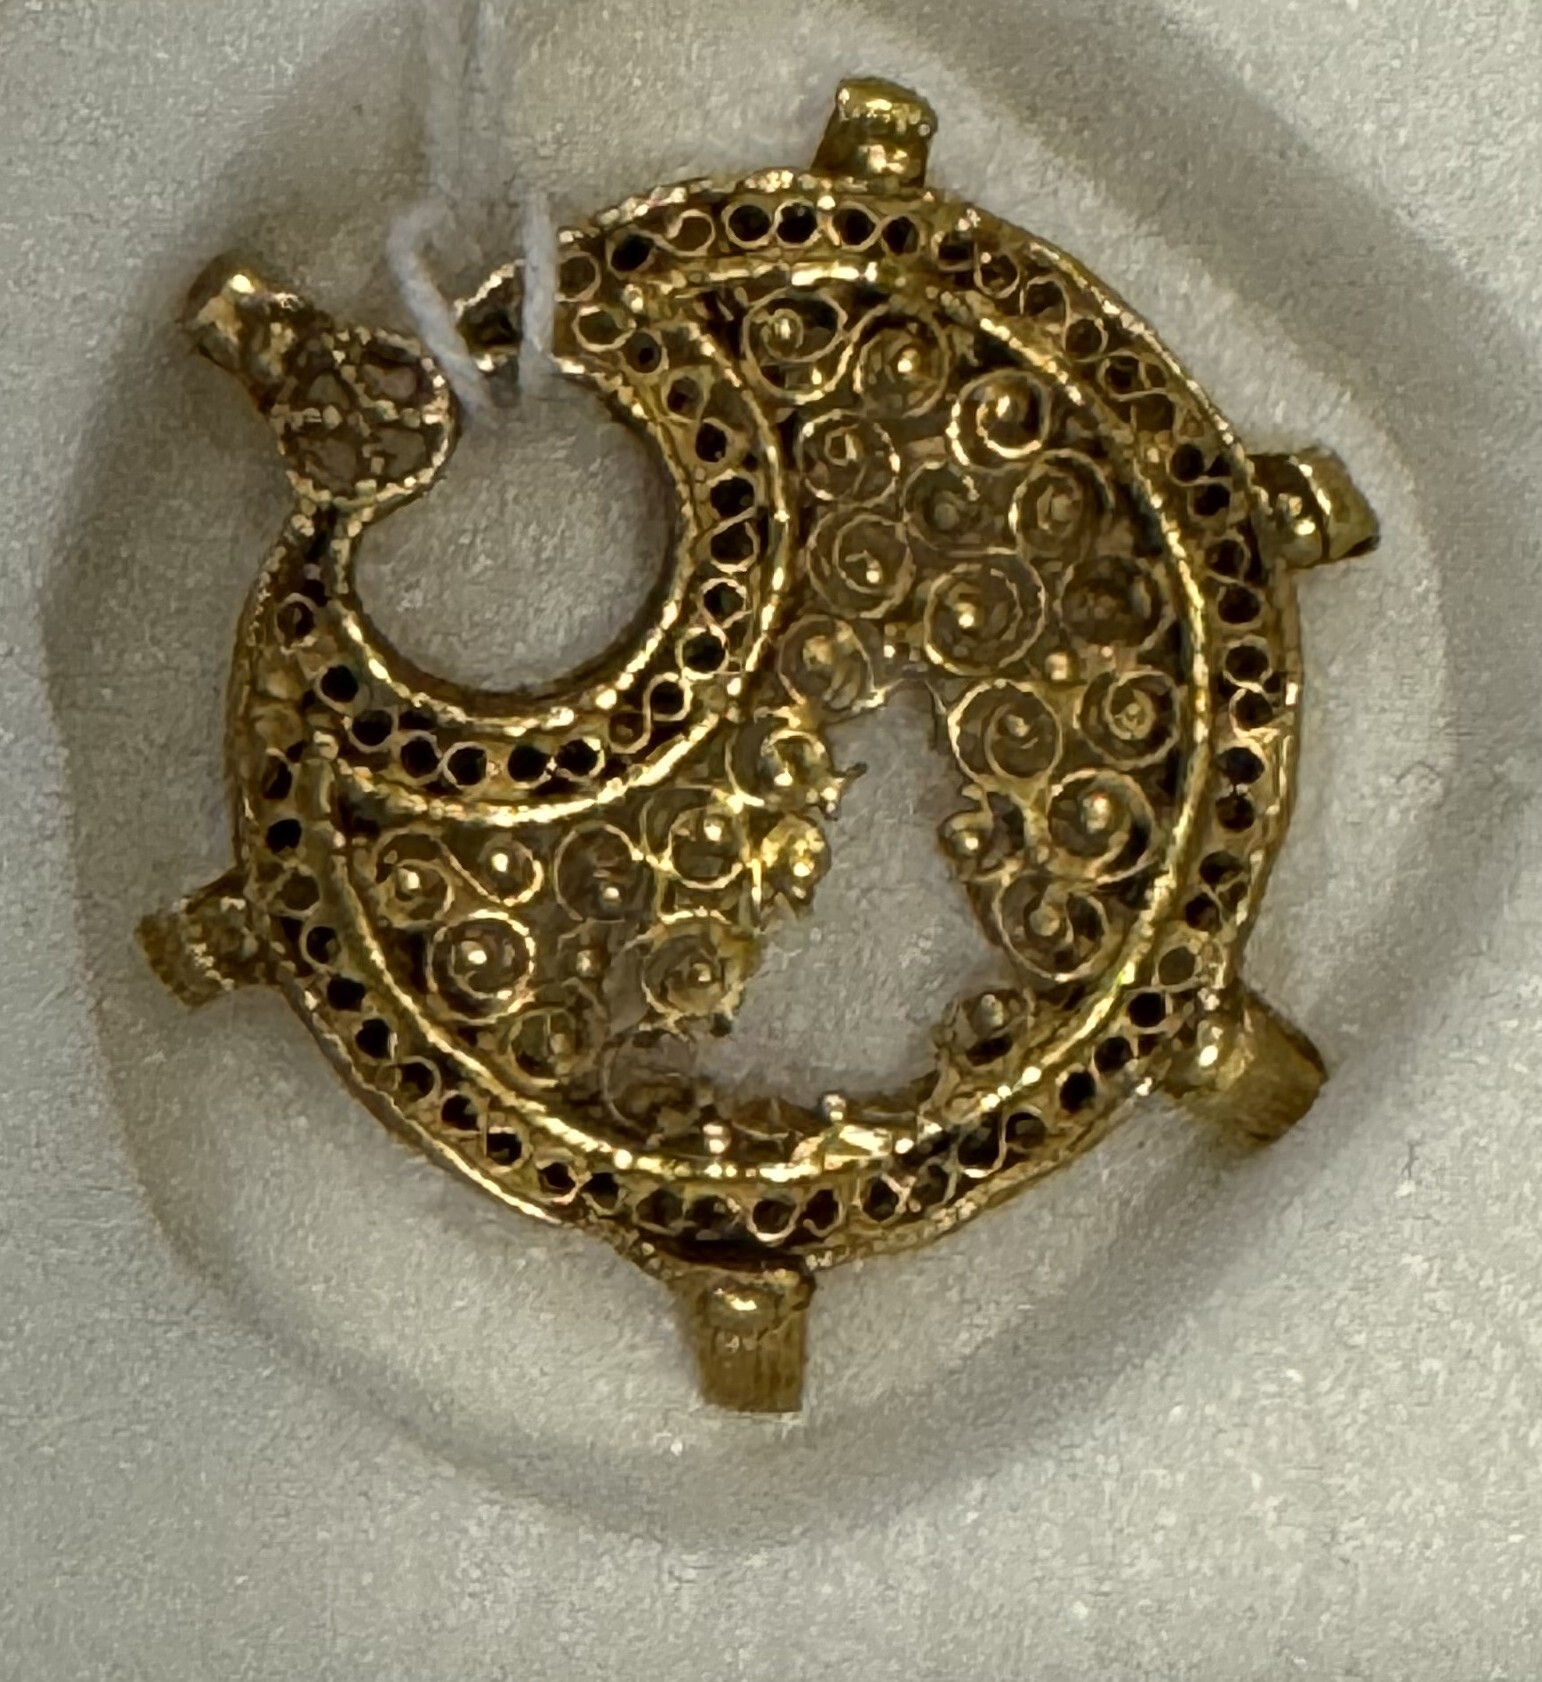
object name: pendant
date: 1001-1100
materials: gold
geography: egypt or syria